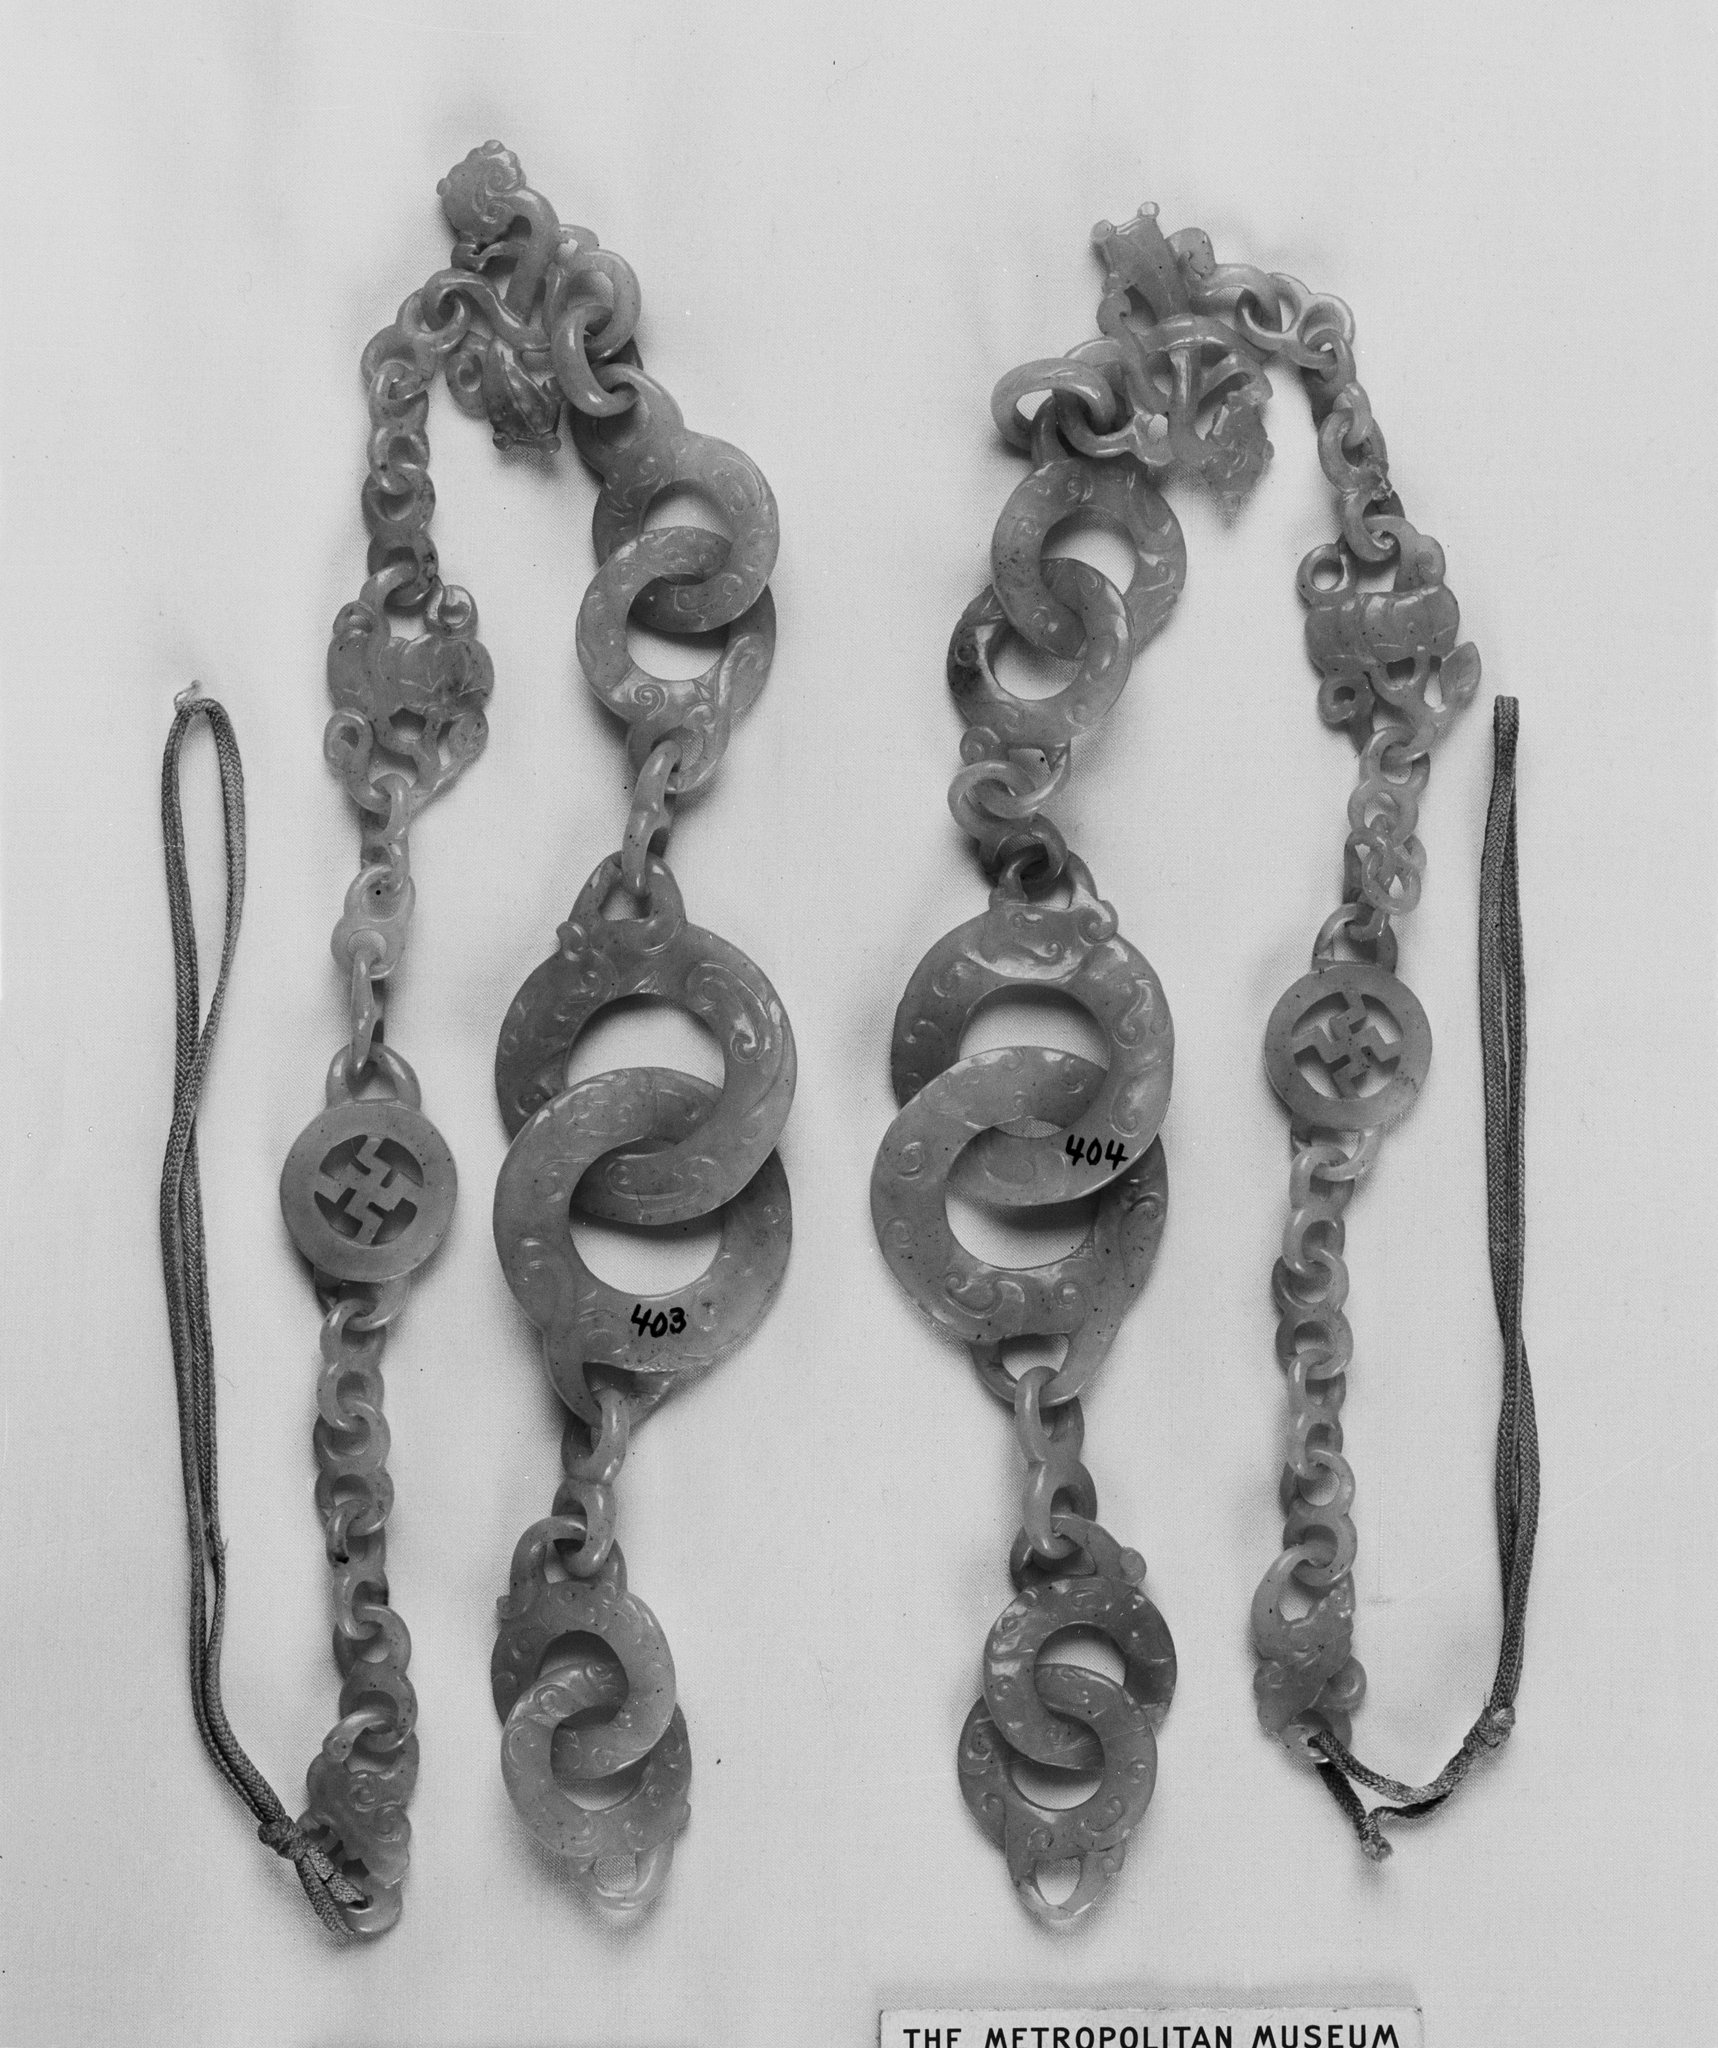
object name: chain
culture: chinese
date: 1368-1644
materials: jade